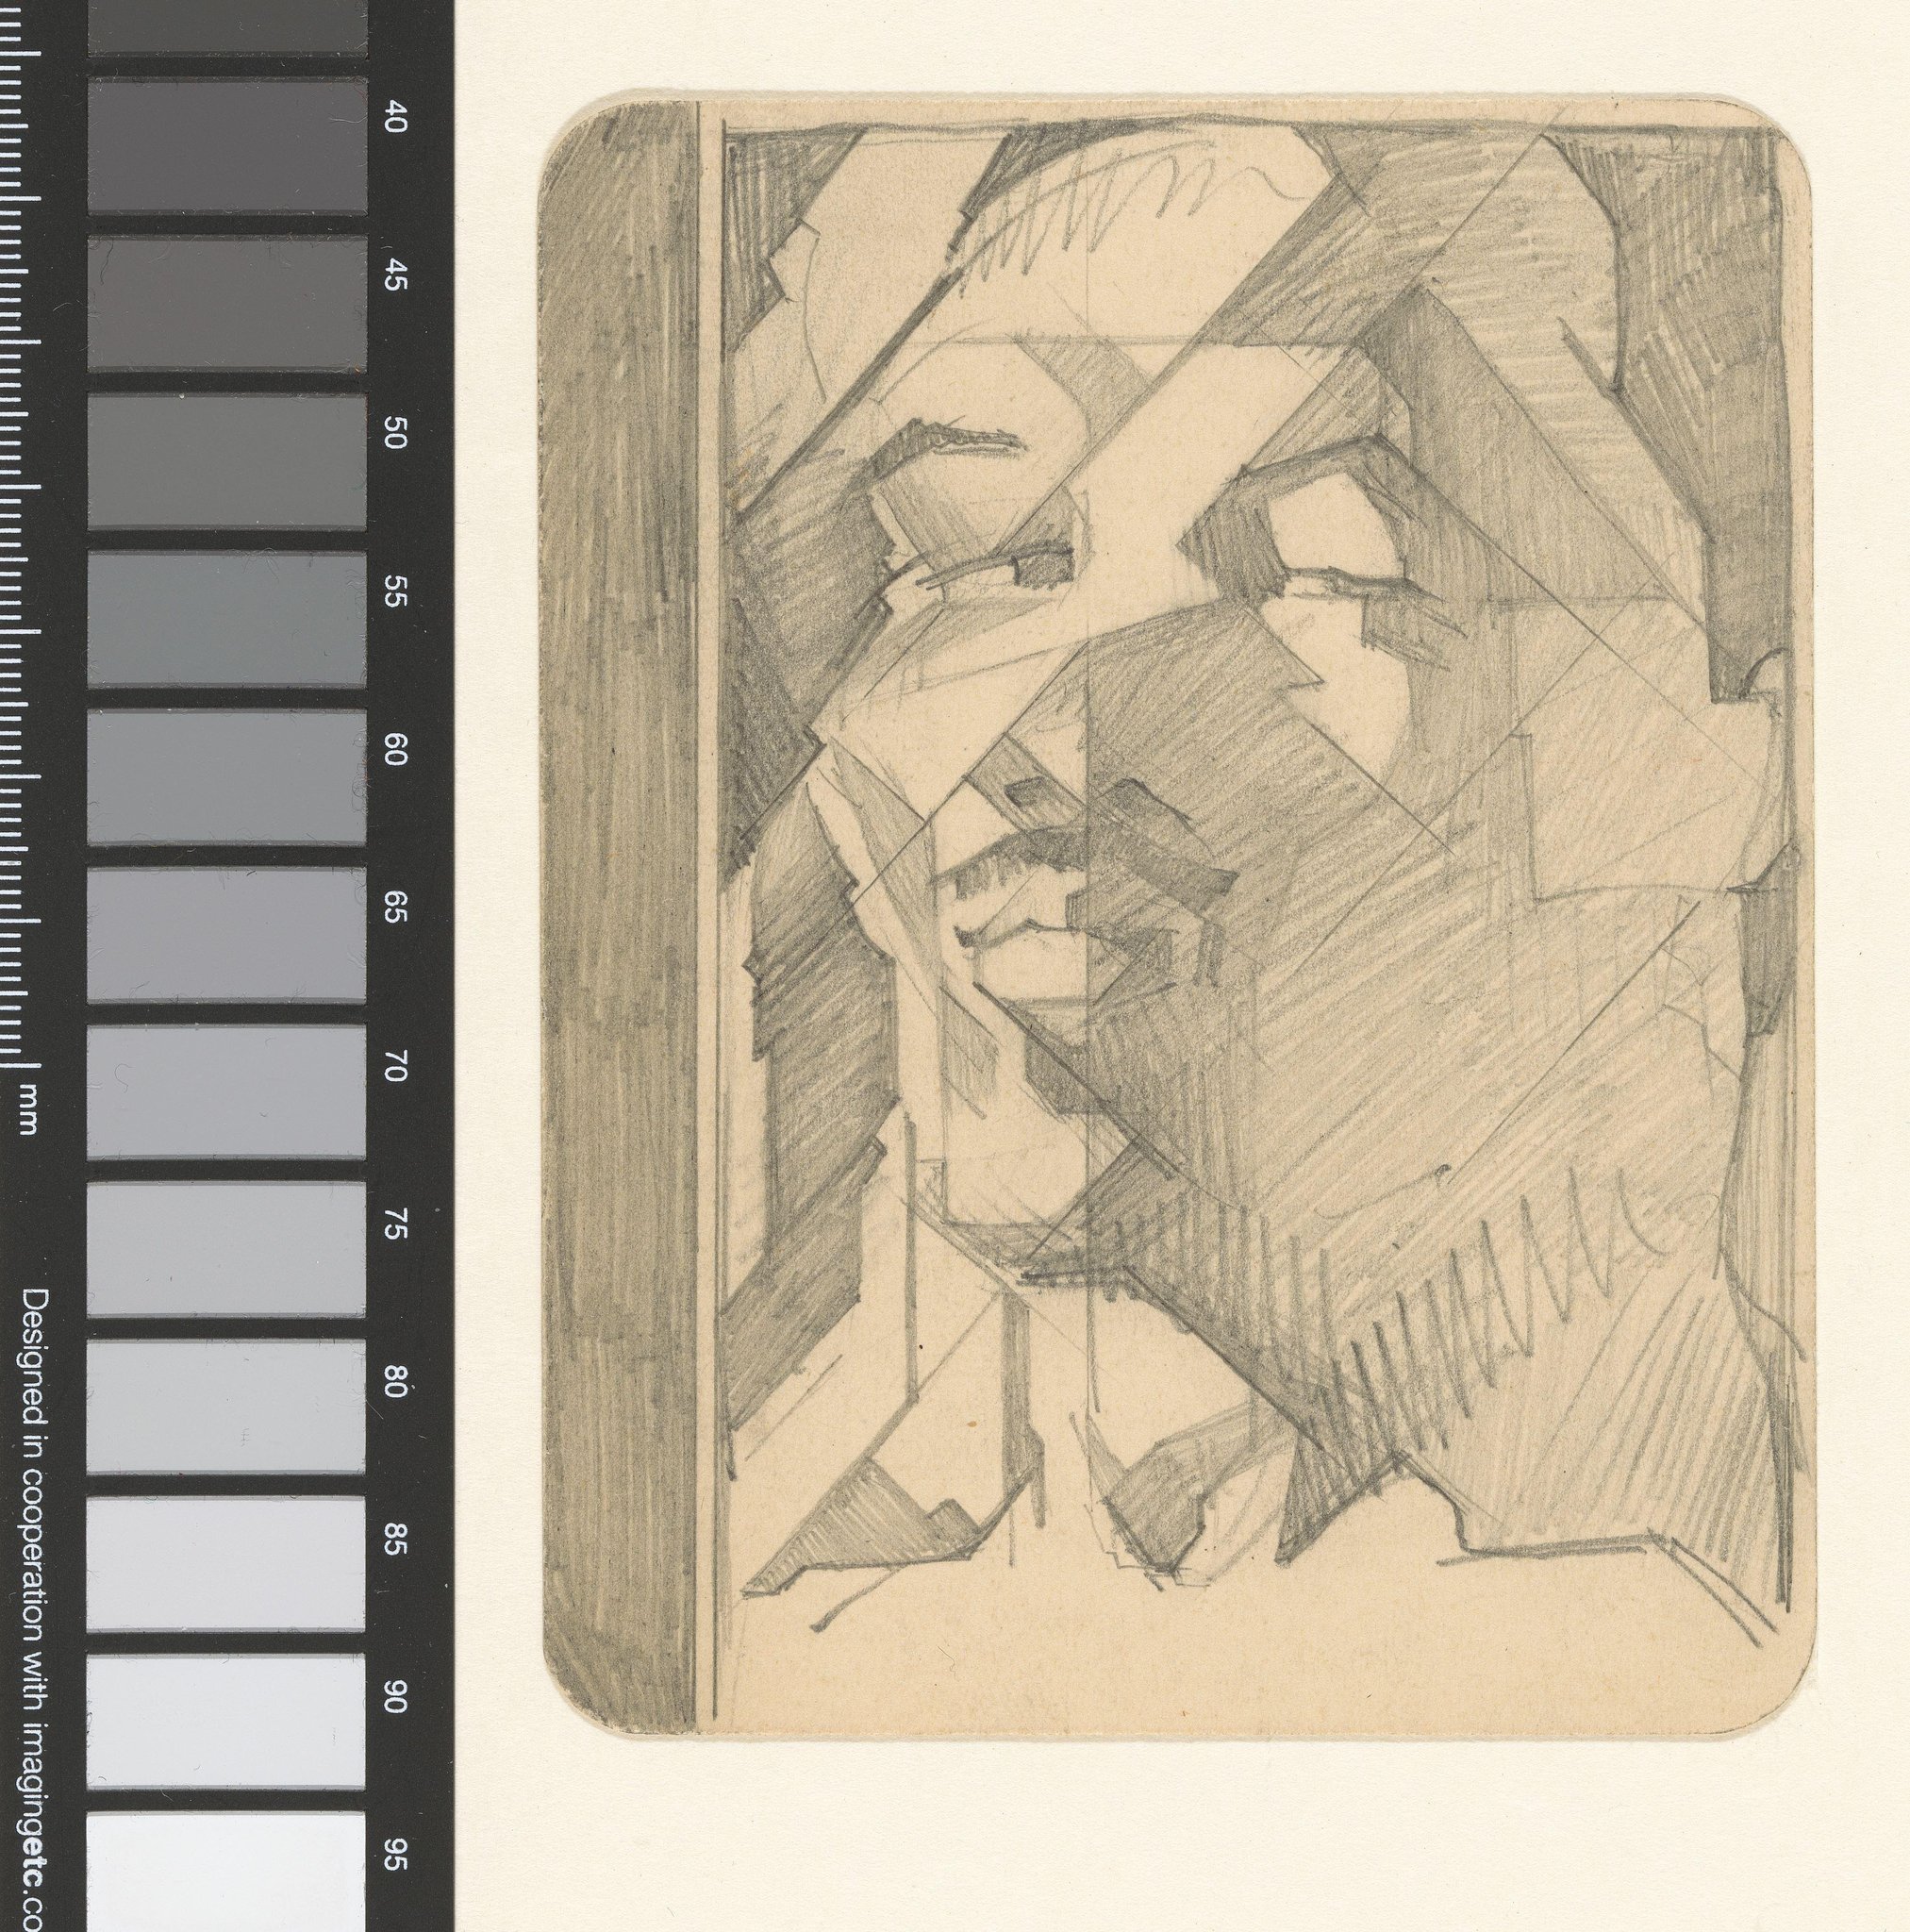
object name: drawing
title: Zelfportret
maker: reijer stolk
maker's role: draughtsman, print maker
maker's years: 1896-1945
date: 1920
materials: paper, pencil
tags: print maker, reijer stolk, historical persons, portrait, self-portrait of artist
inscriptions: collector's mark: Lugt 2228, collector's mark: Lugt 2760